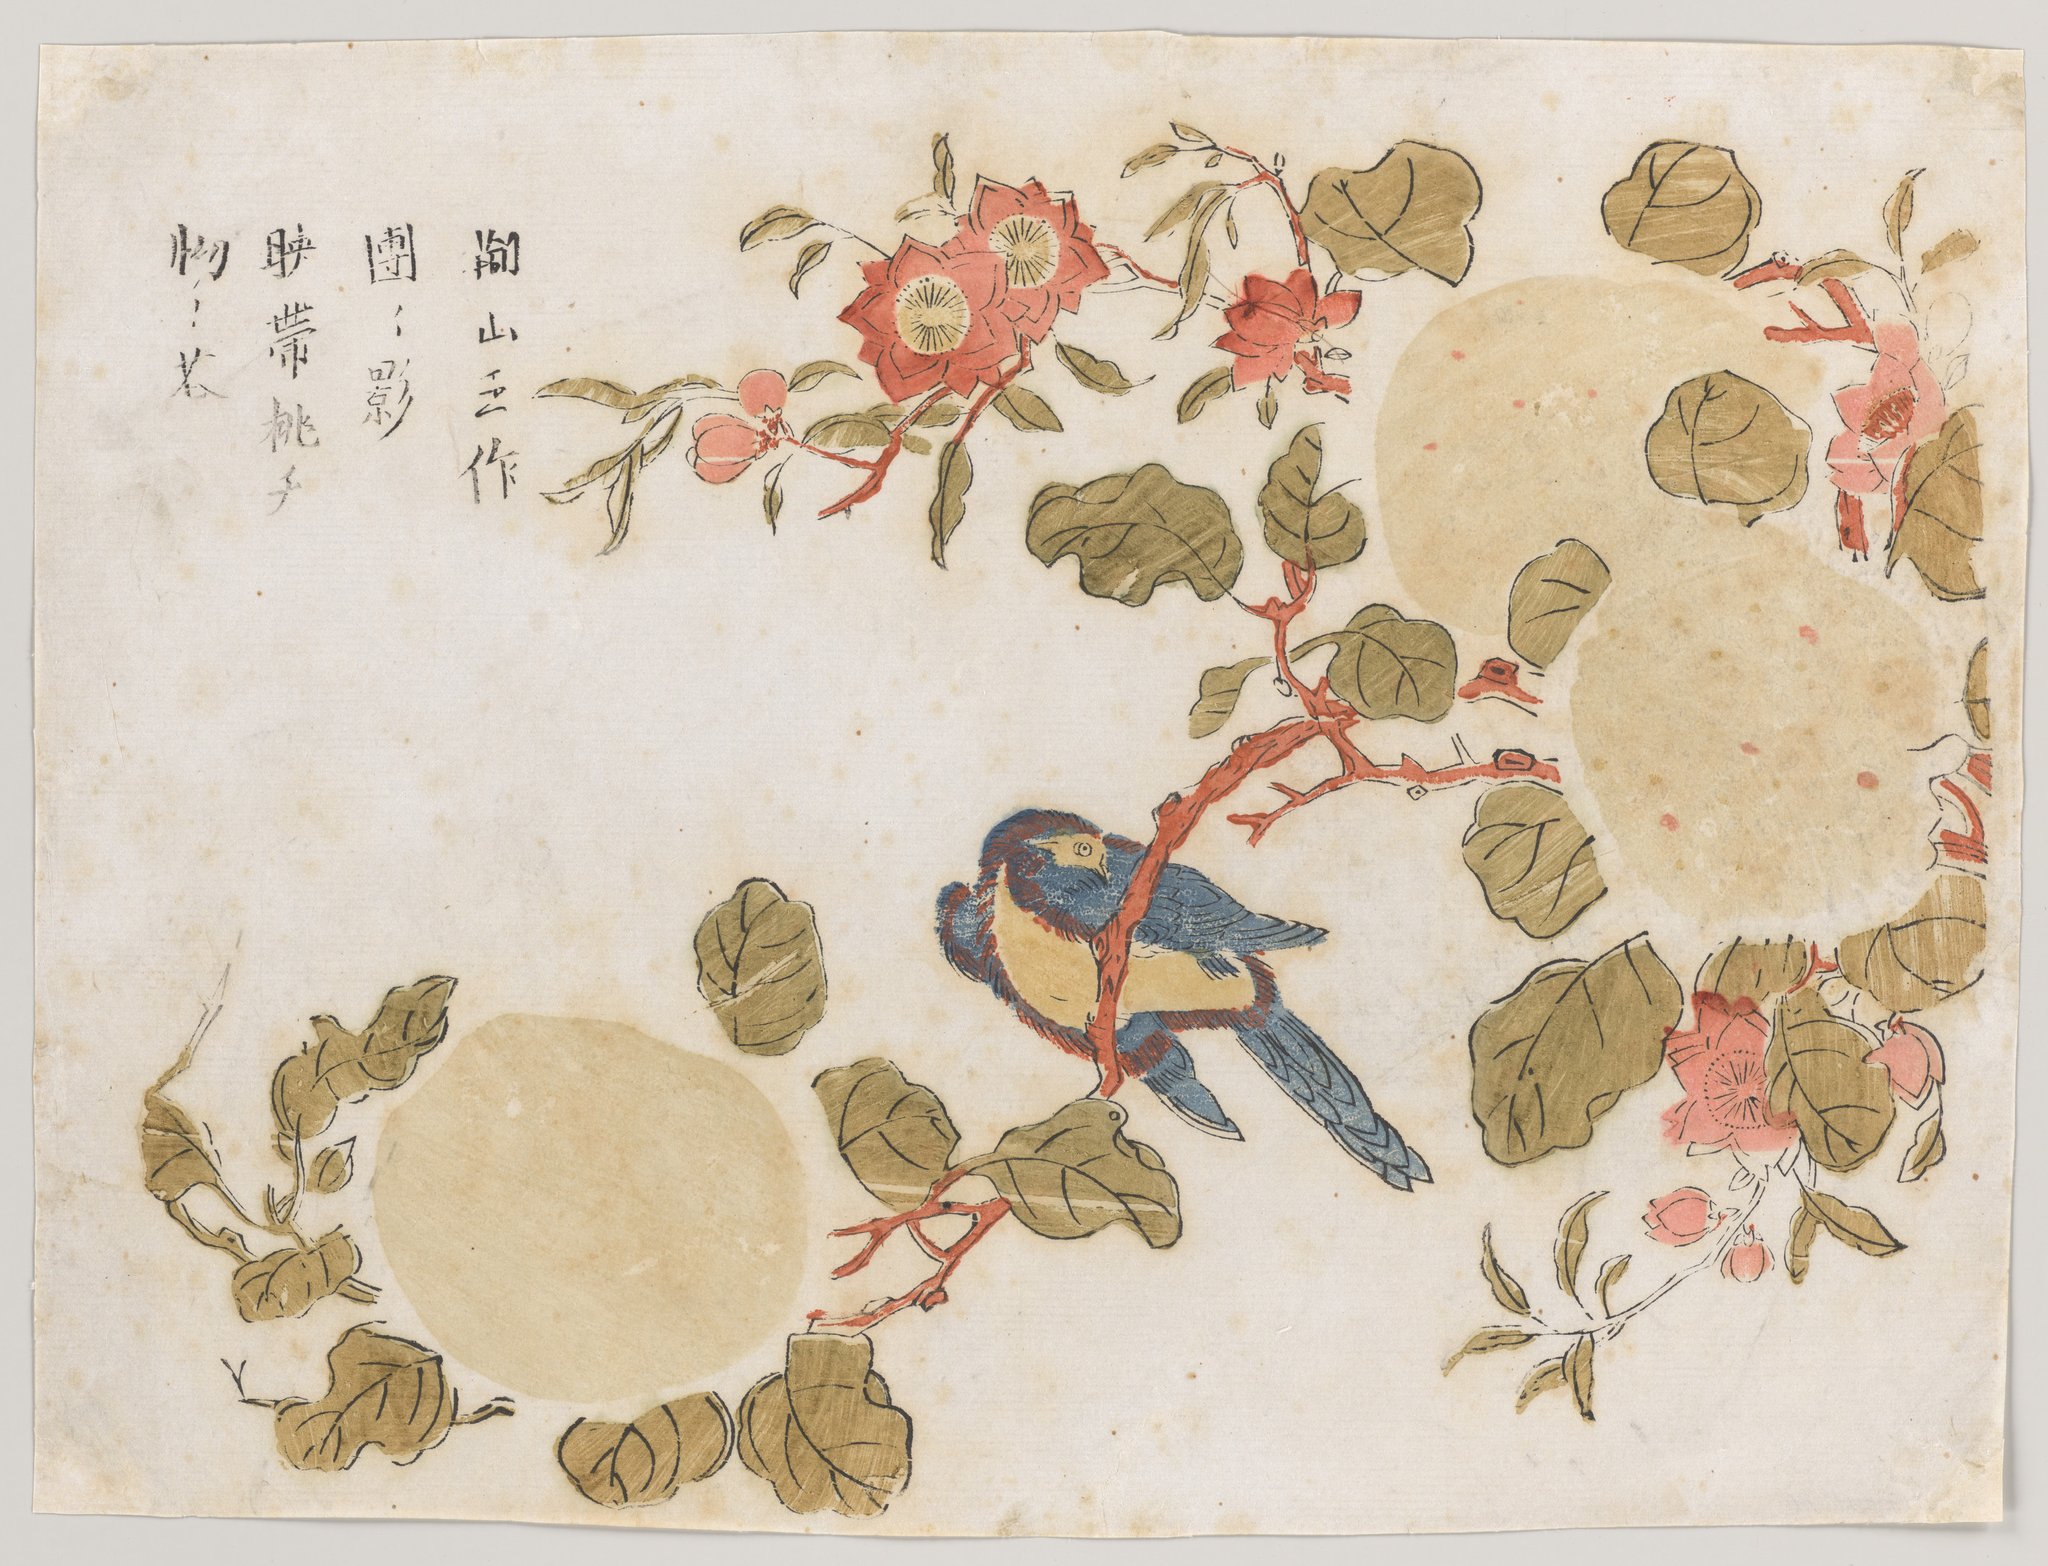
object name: print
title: Bird on Viburnum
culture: chinese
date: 1701-1800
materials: ink, paper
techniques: polychrome, woodblock print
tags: birds